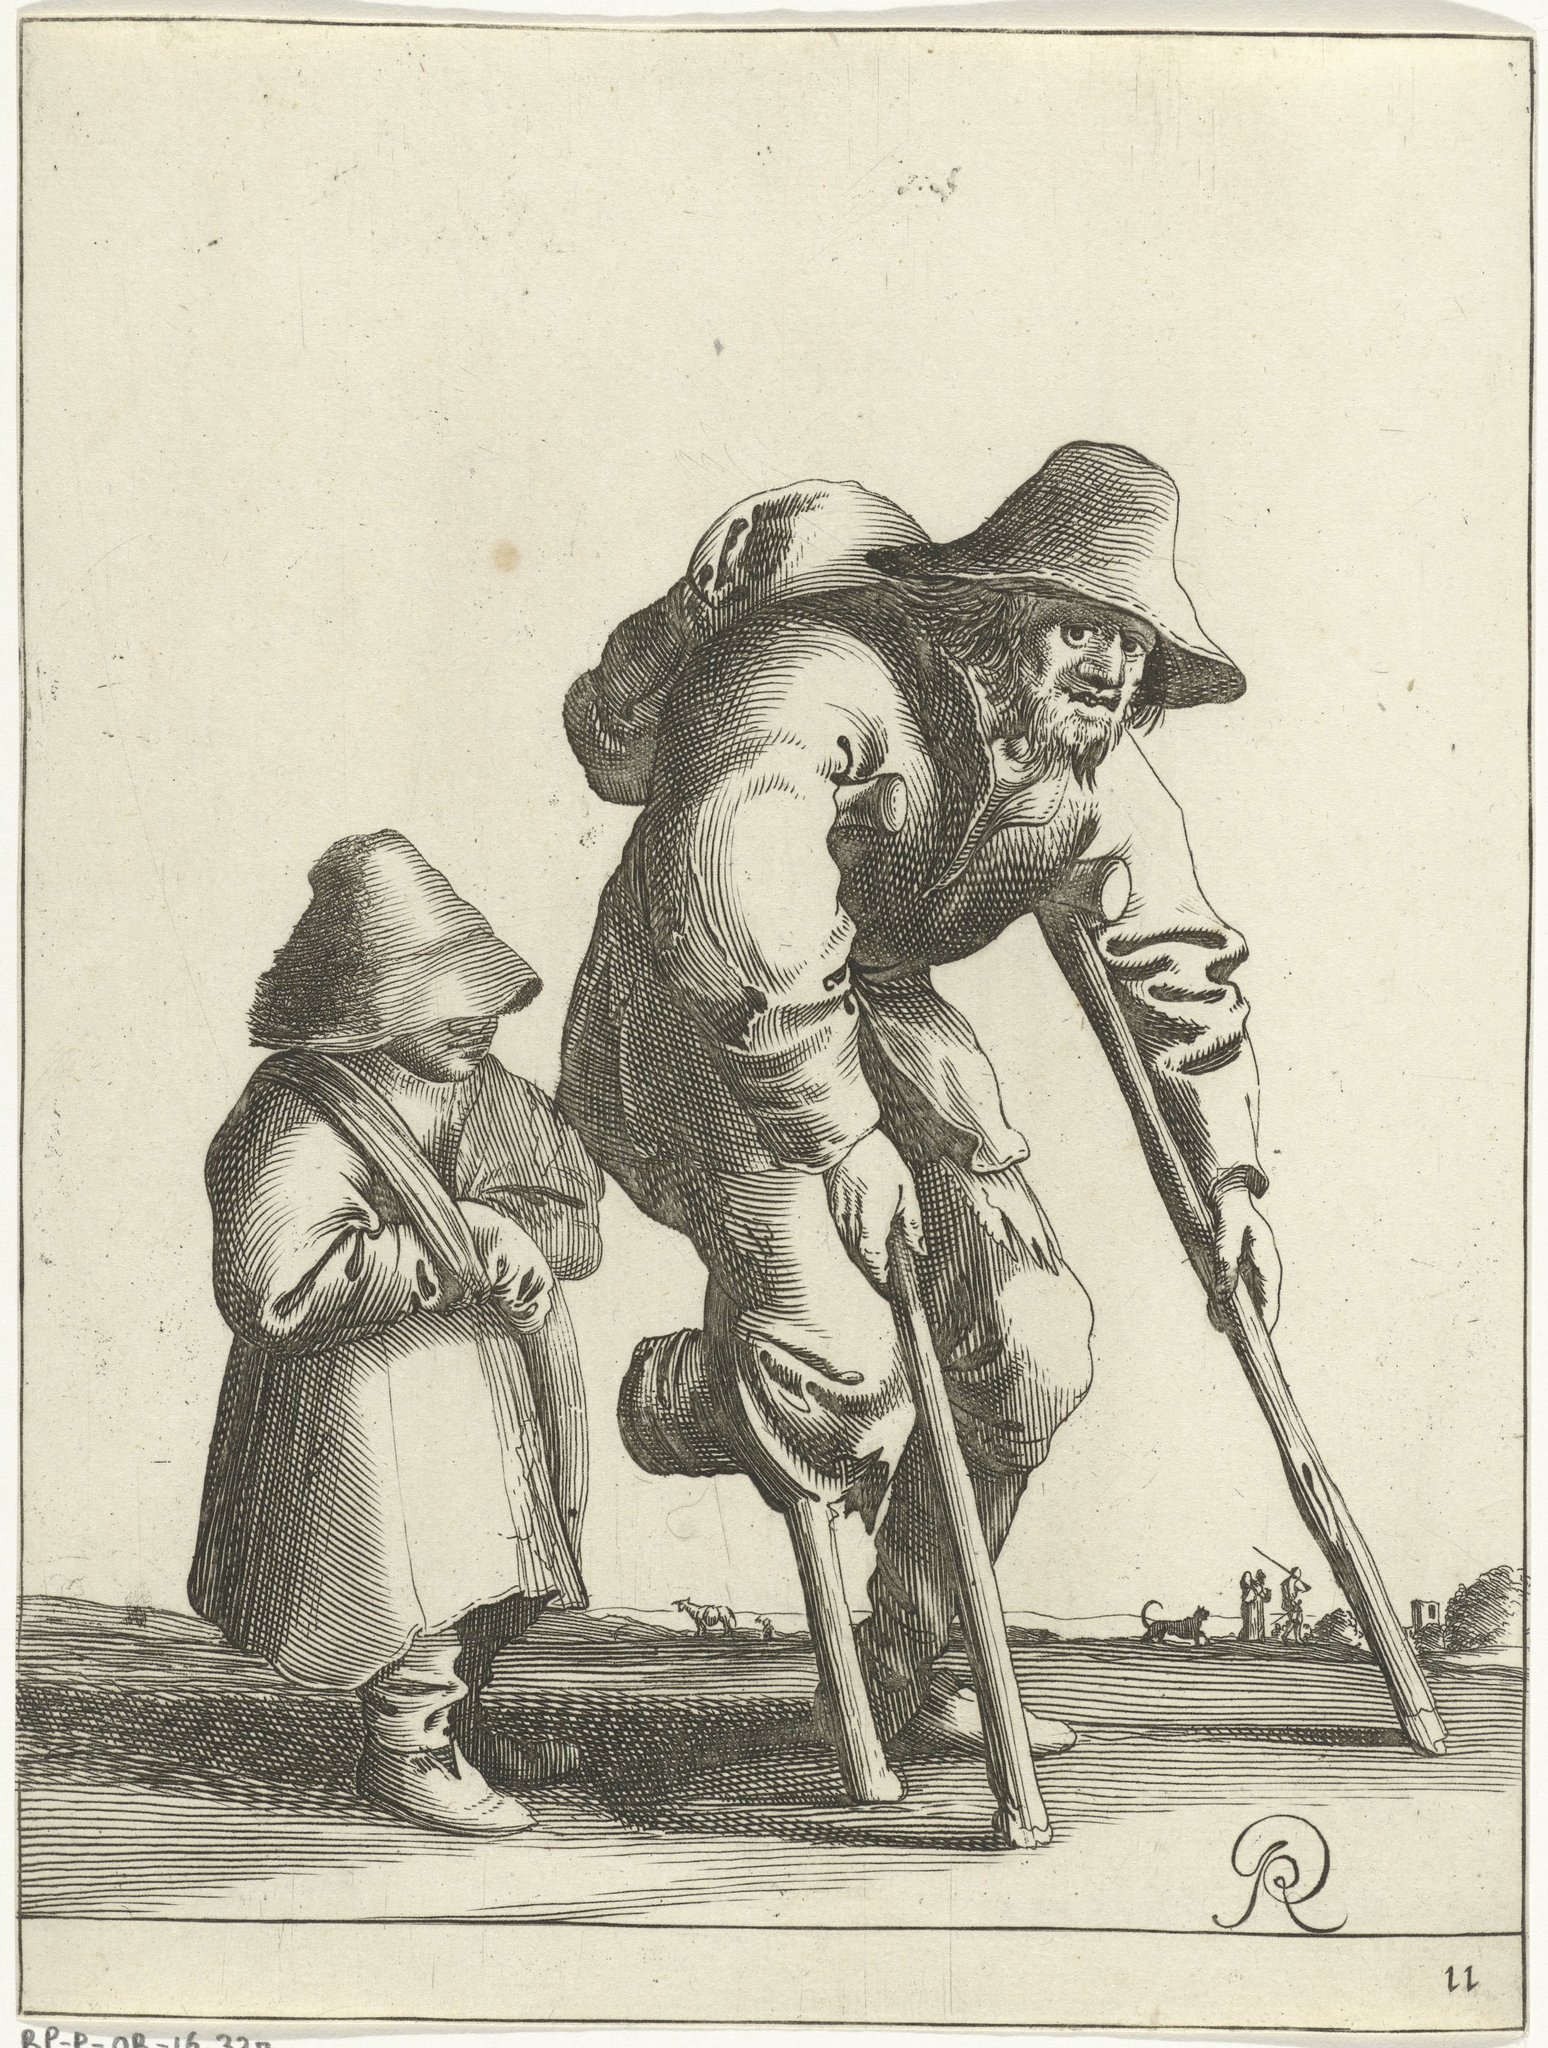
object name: print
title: Bedelaars en boeren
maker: pieter jansz quast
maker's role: draughtsman, painter, print maker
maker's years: 1605-1647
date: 1634-1638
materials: paper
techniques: engraving, etching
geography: the hague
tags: crutches, wooden leg, child, person with a physical disability, beggar, dog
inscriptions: collector's mark: Lugt 2228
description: Een bedelaar met een houten been steunt op twee krukken. Naast hem loopt een kind met de arm in een mitella. Op de achtergrond twee figuren, een hond en vee. De prent maakt deel uit van een serie van zesentwintig prenten met bedelaars en boeren.